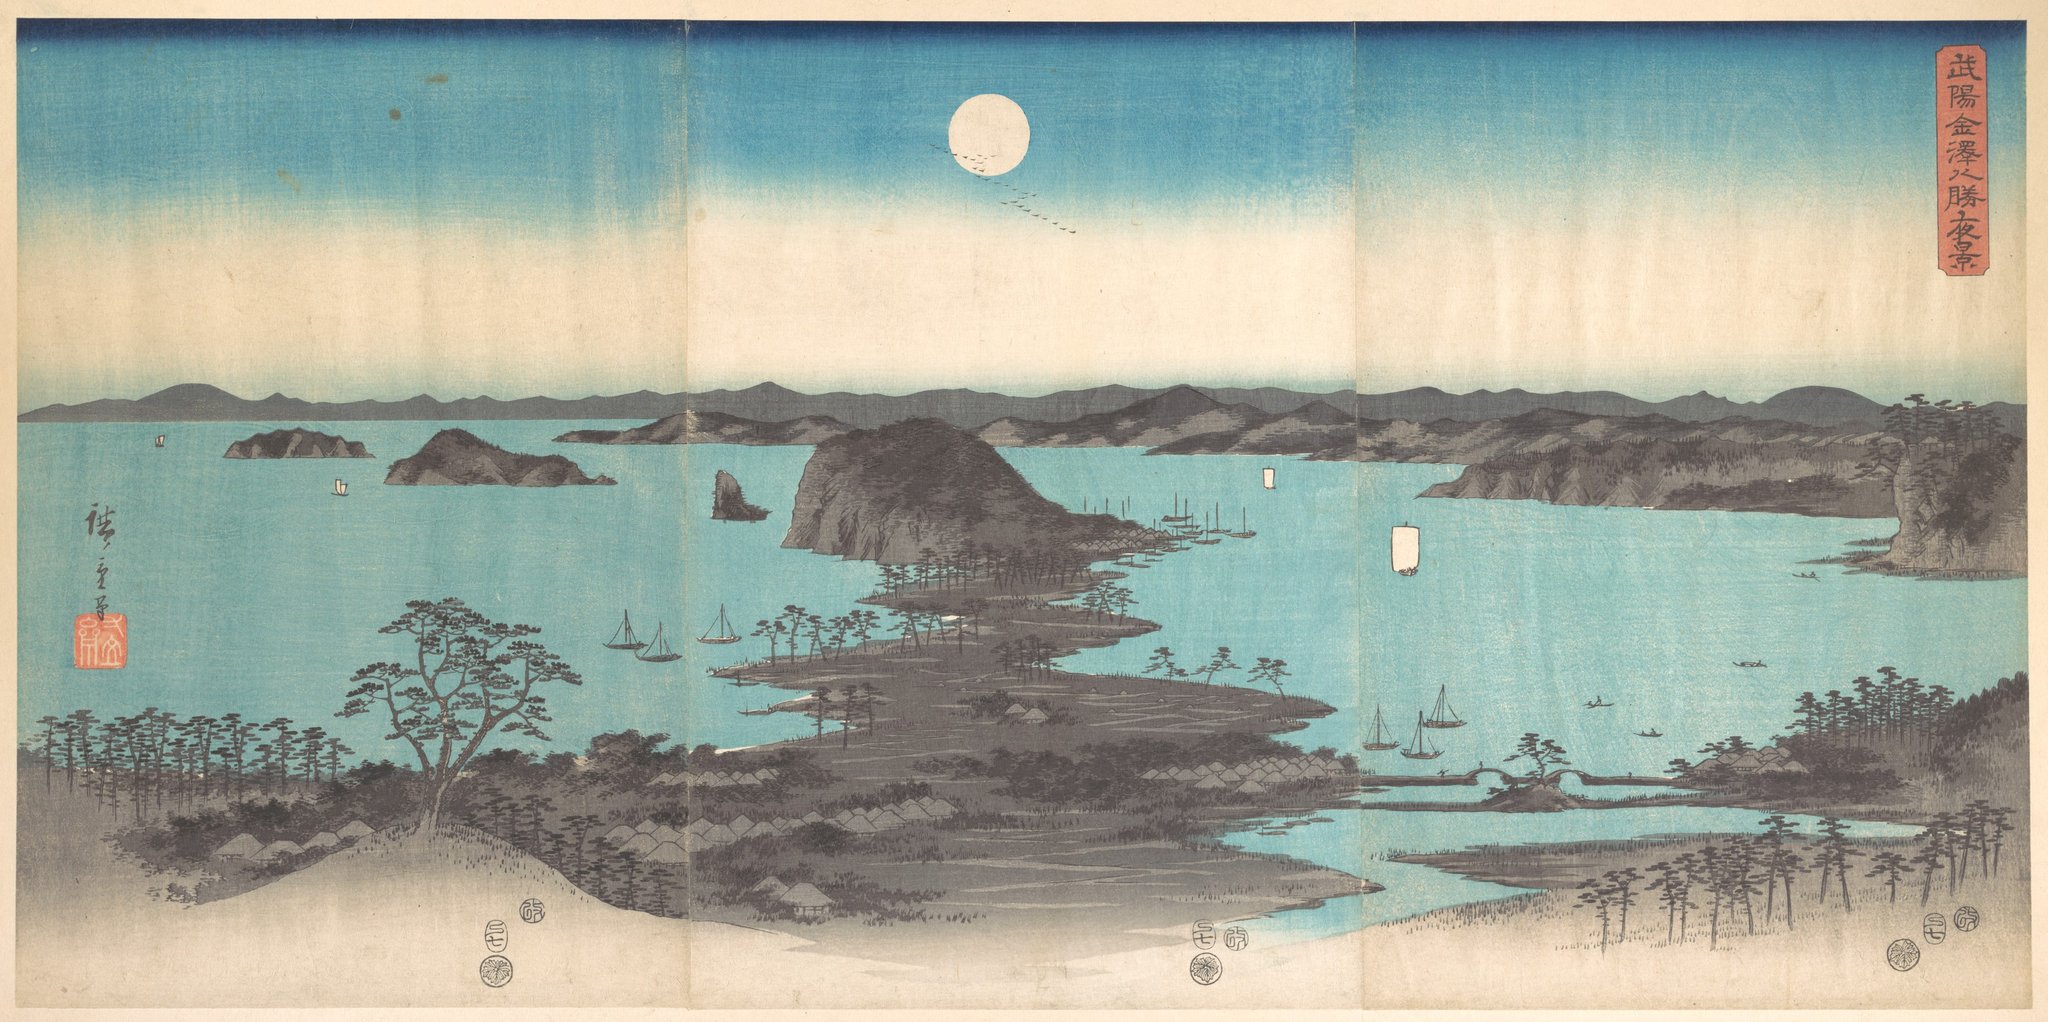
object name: woodblock print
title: Panorama of the Eight Views of Kanasawa under a Full Moon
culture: japanese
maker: utagawa hiroshige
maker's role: artist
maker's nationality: japanese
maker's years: 1797-1858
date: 1857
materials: ink, paper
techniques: woodblock print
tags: moon,landscapes